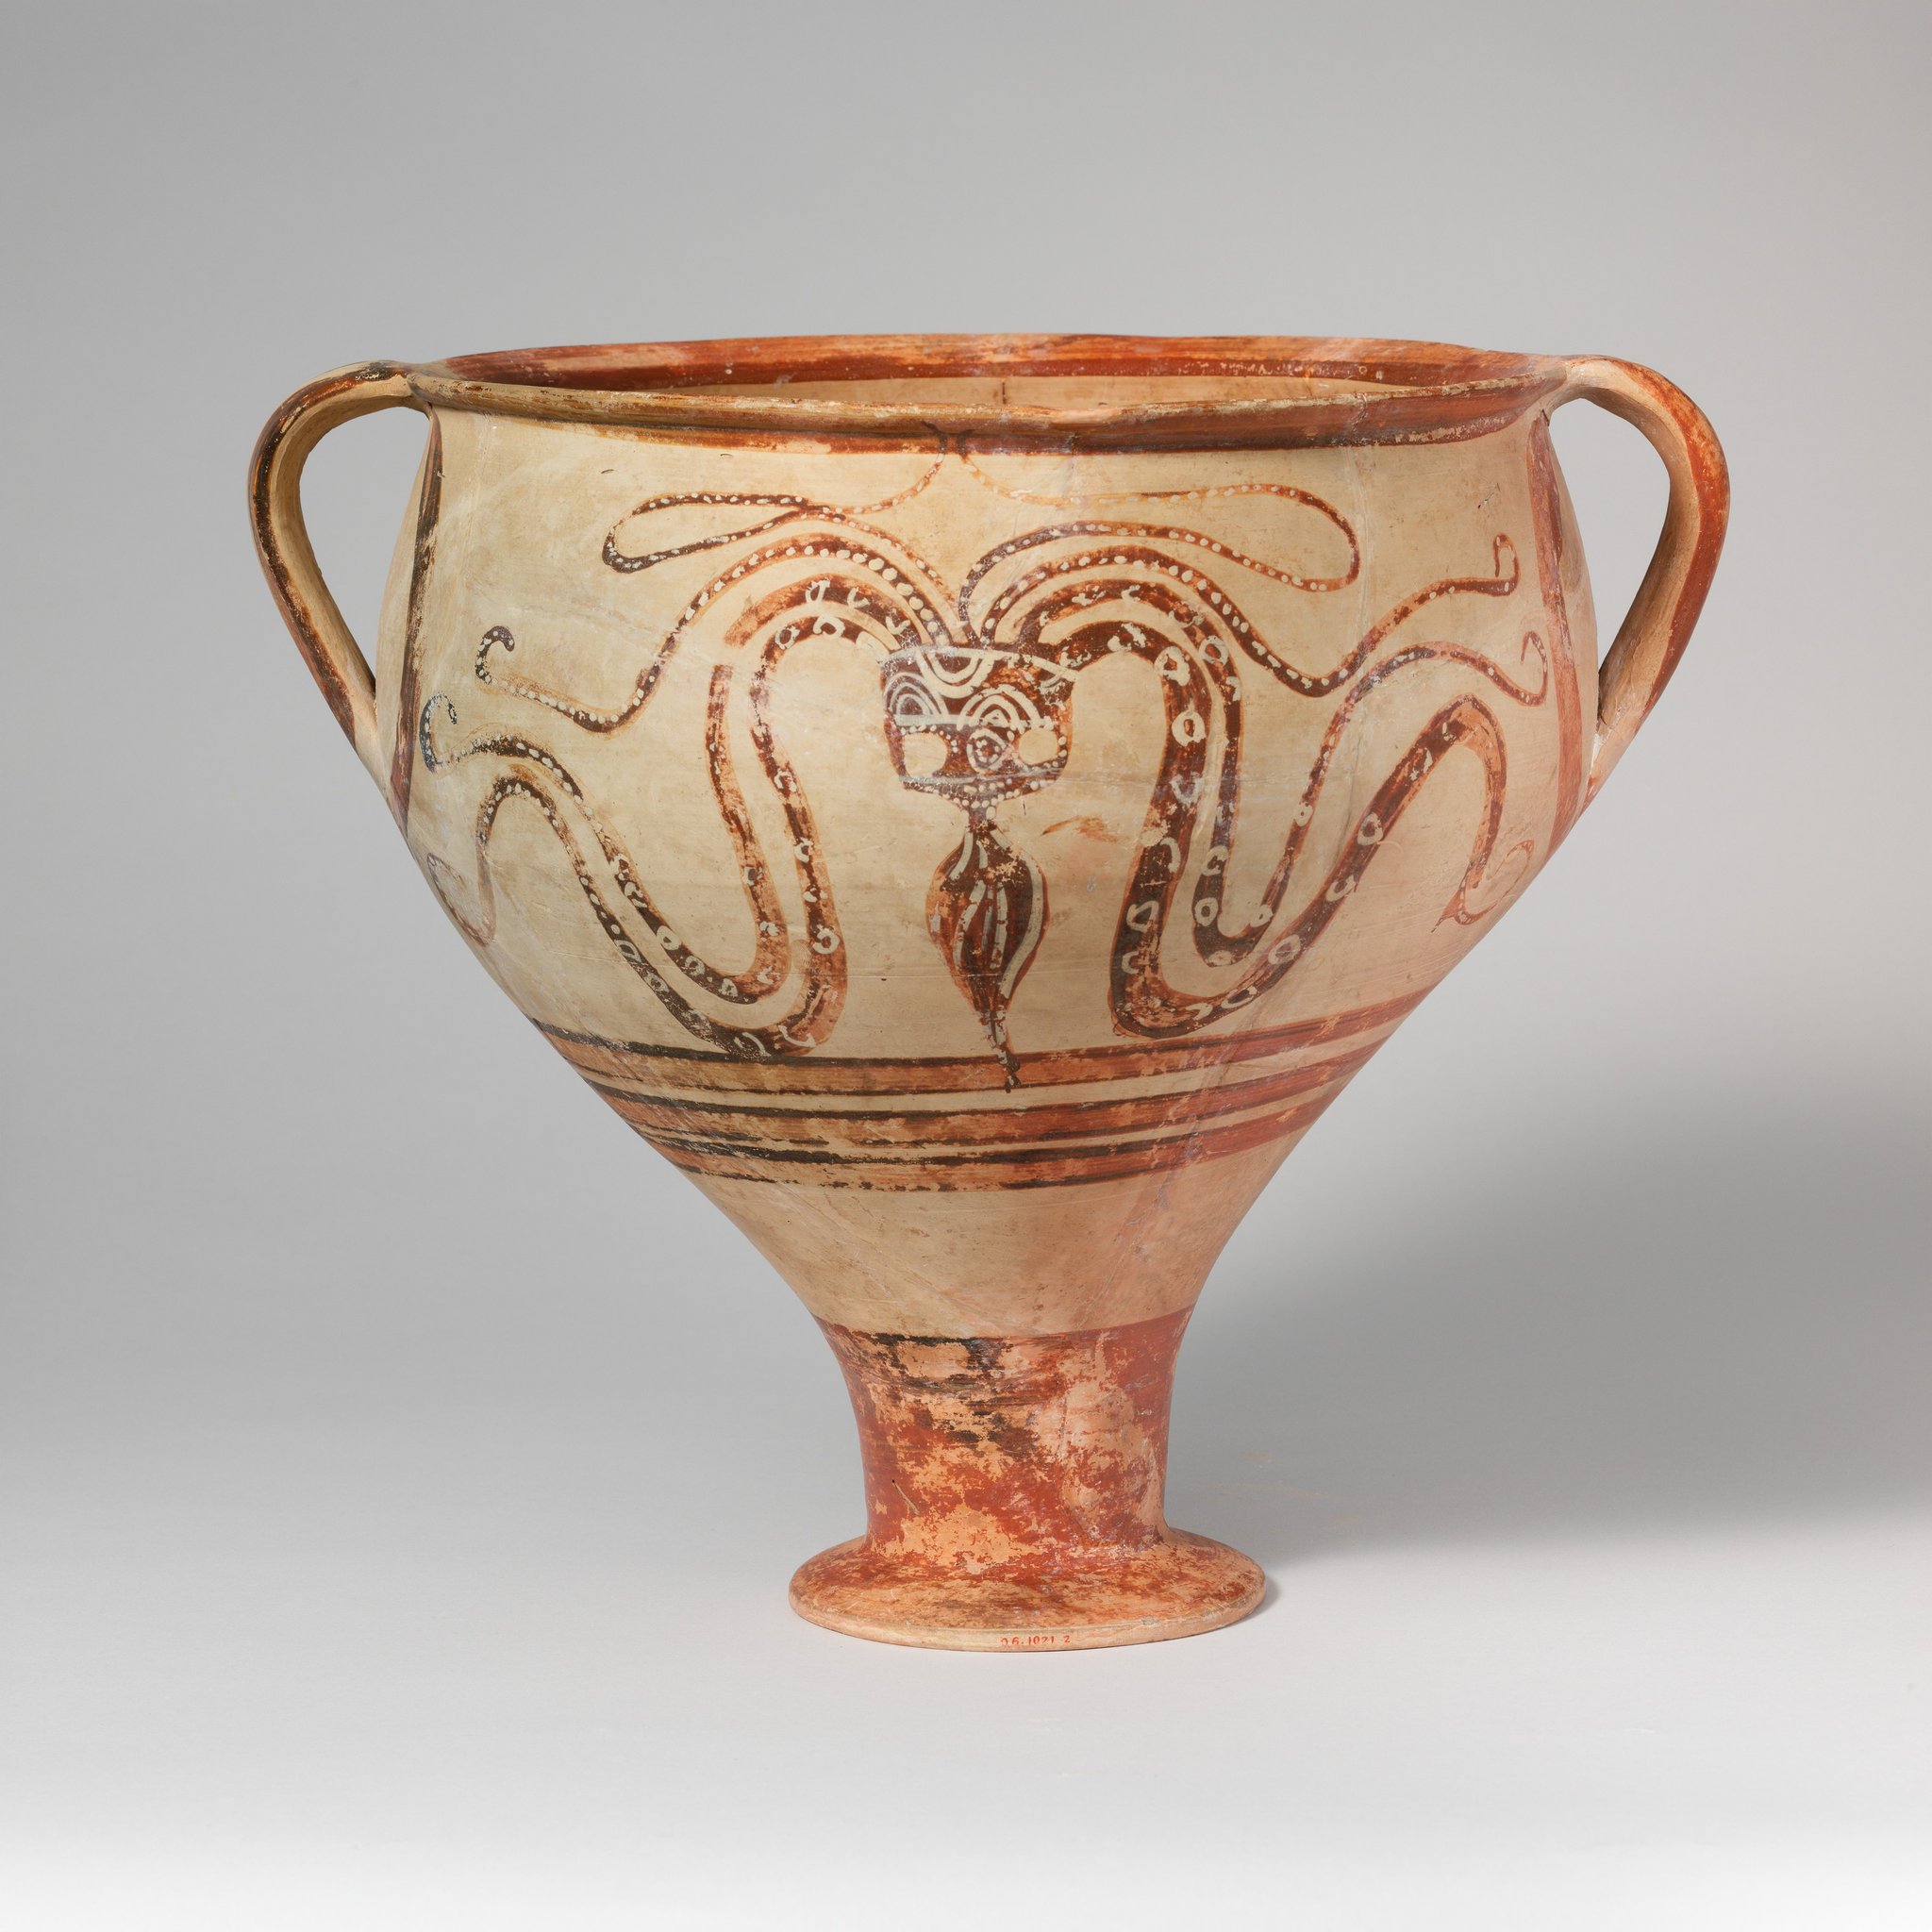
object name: krater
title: Terracotta krater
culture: mycenaean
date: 1300-1201 BCE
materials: terracotta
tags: octopus